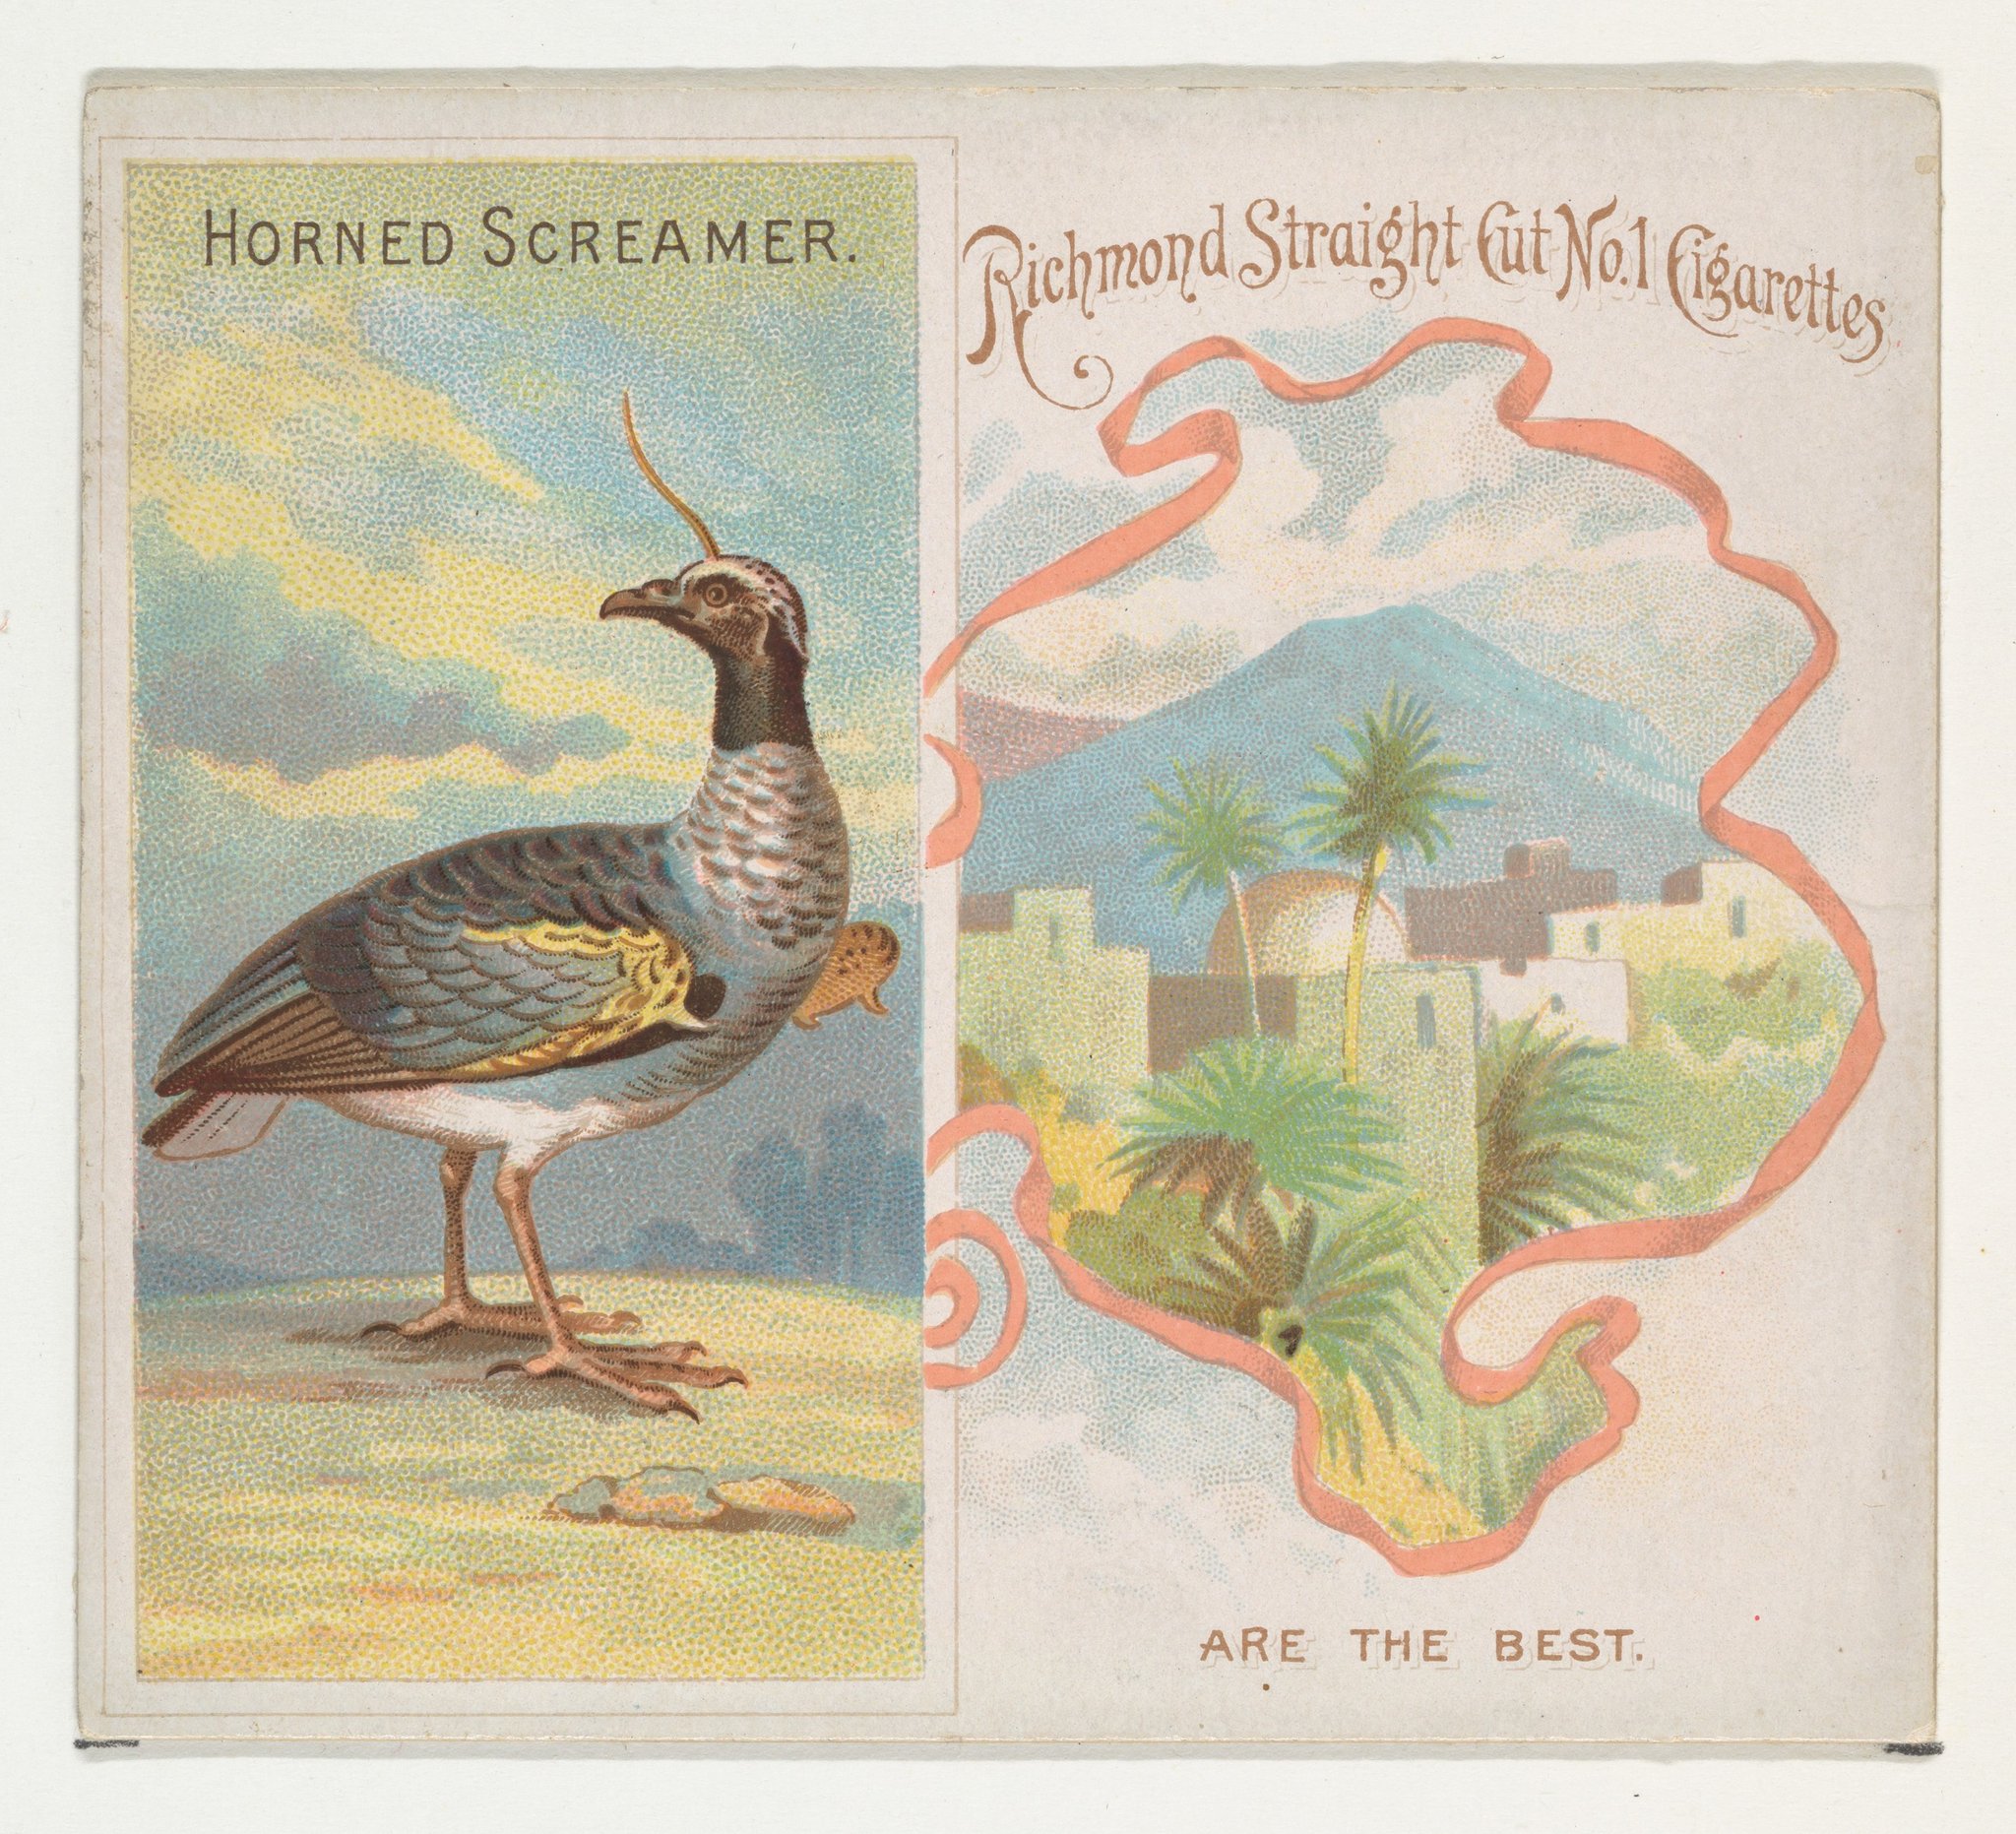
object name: print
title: Horned Screamer, from Birds of the Tropics series (N38) for Allen & Ginter Cigarettes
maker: allen & ginter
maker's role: publisher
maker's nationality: american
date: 1889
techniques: color lithograph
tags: birds